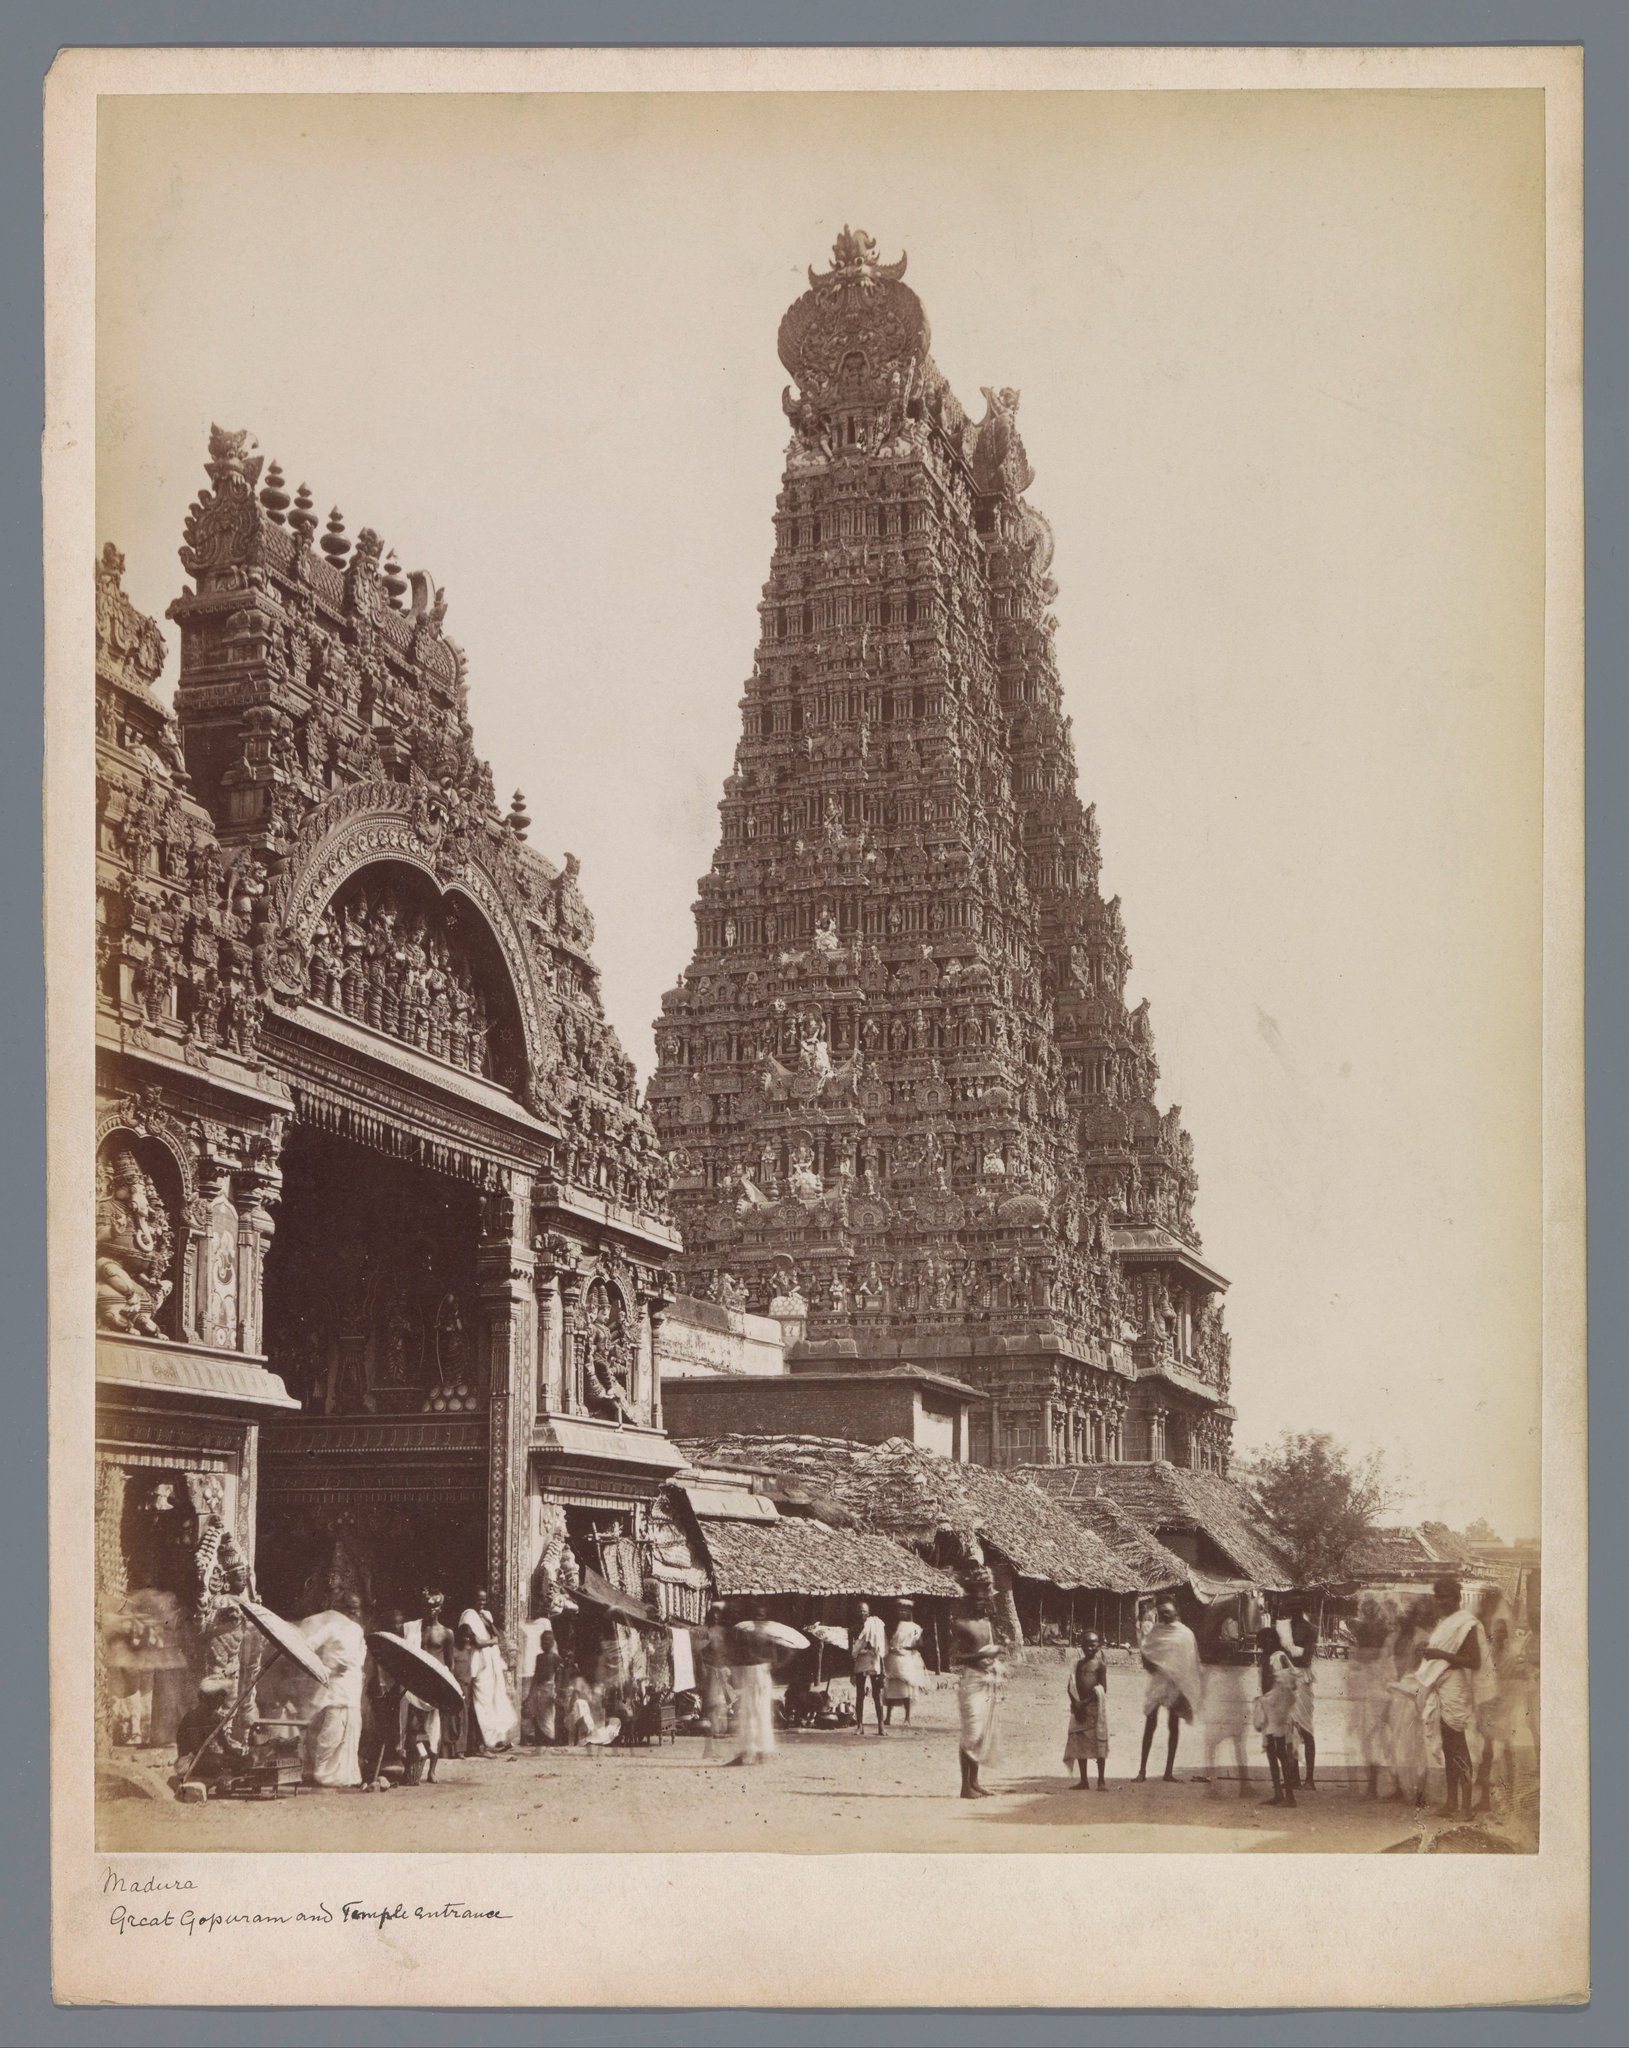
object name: photograph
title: Entrance gate and Gopuram of the Meenakshi temple at Madurai, Tamil Nadu, India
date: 1878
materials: cardboard, paper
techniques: albumen print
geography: madura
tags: temple, shrine ~ hinduism, buddhism, jainism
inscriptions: title: ‘Madura/ Great Gopuram and Temple Entrance’, number: ‘1’